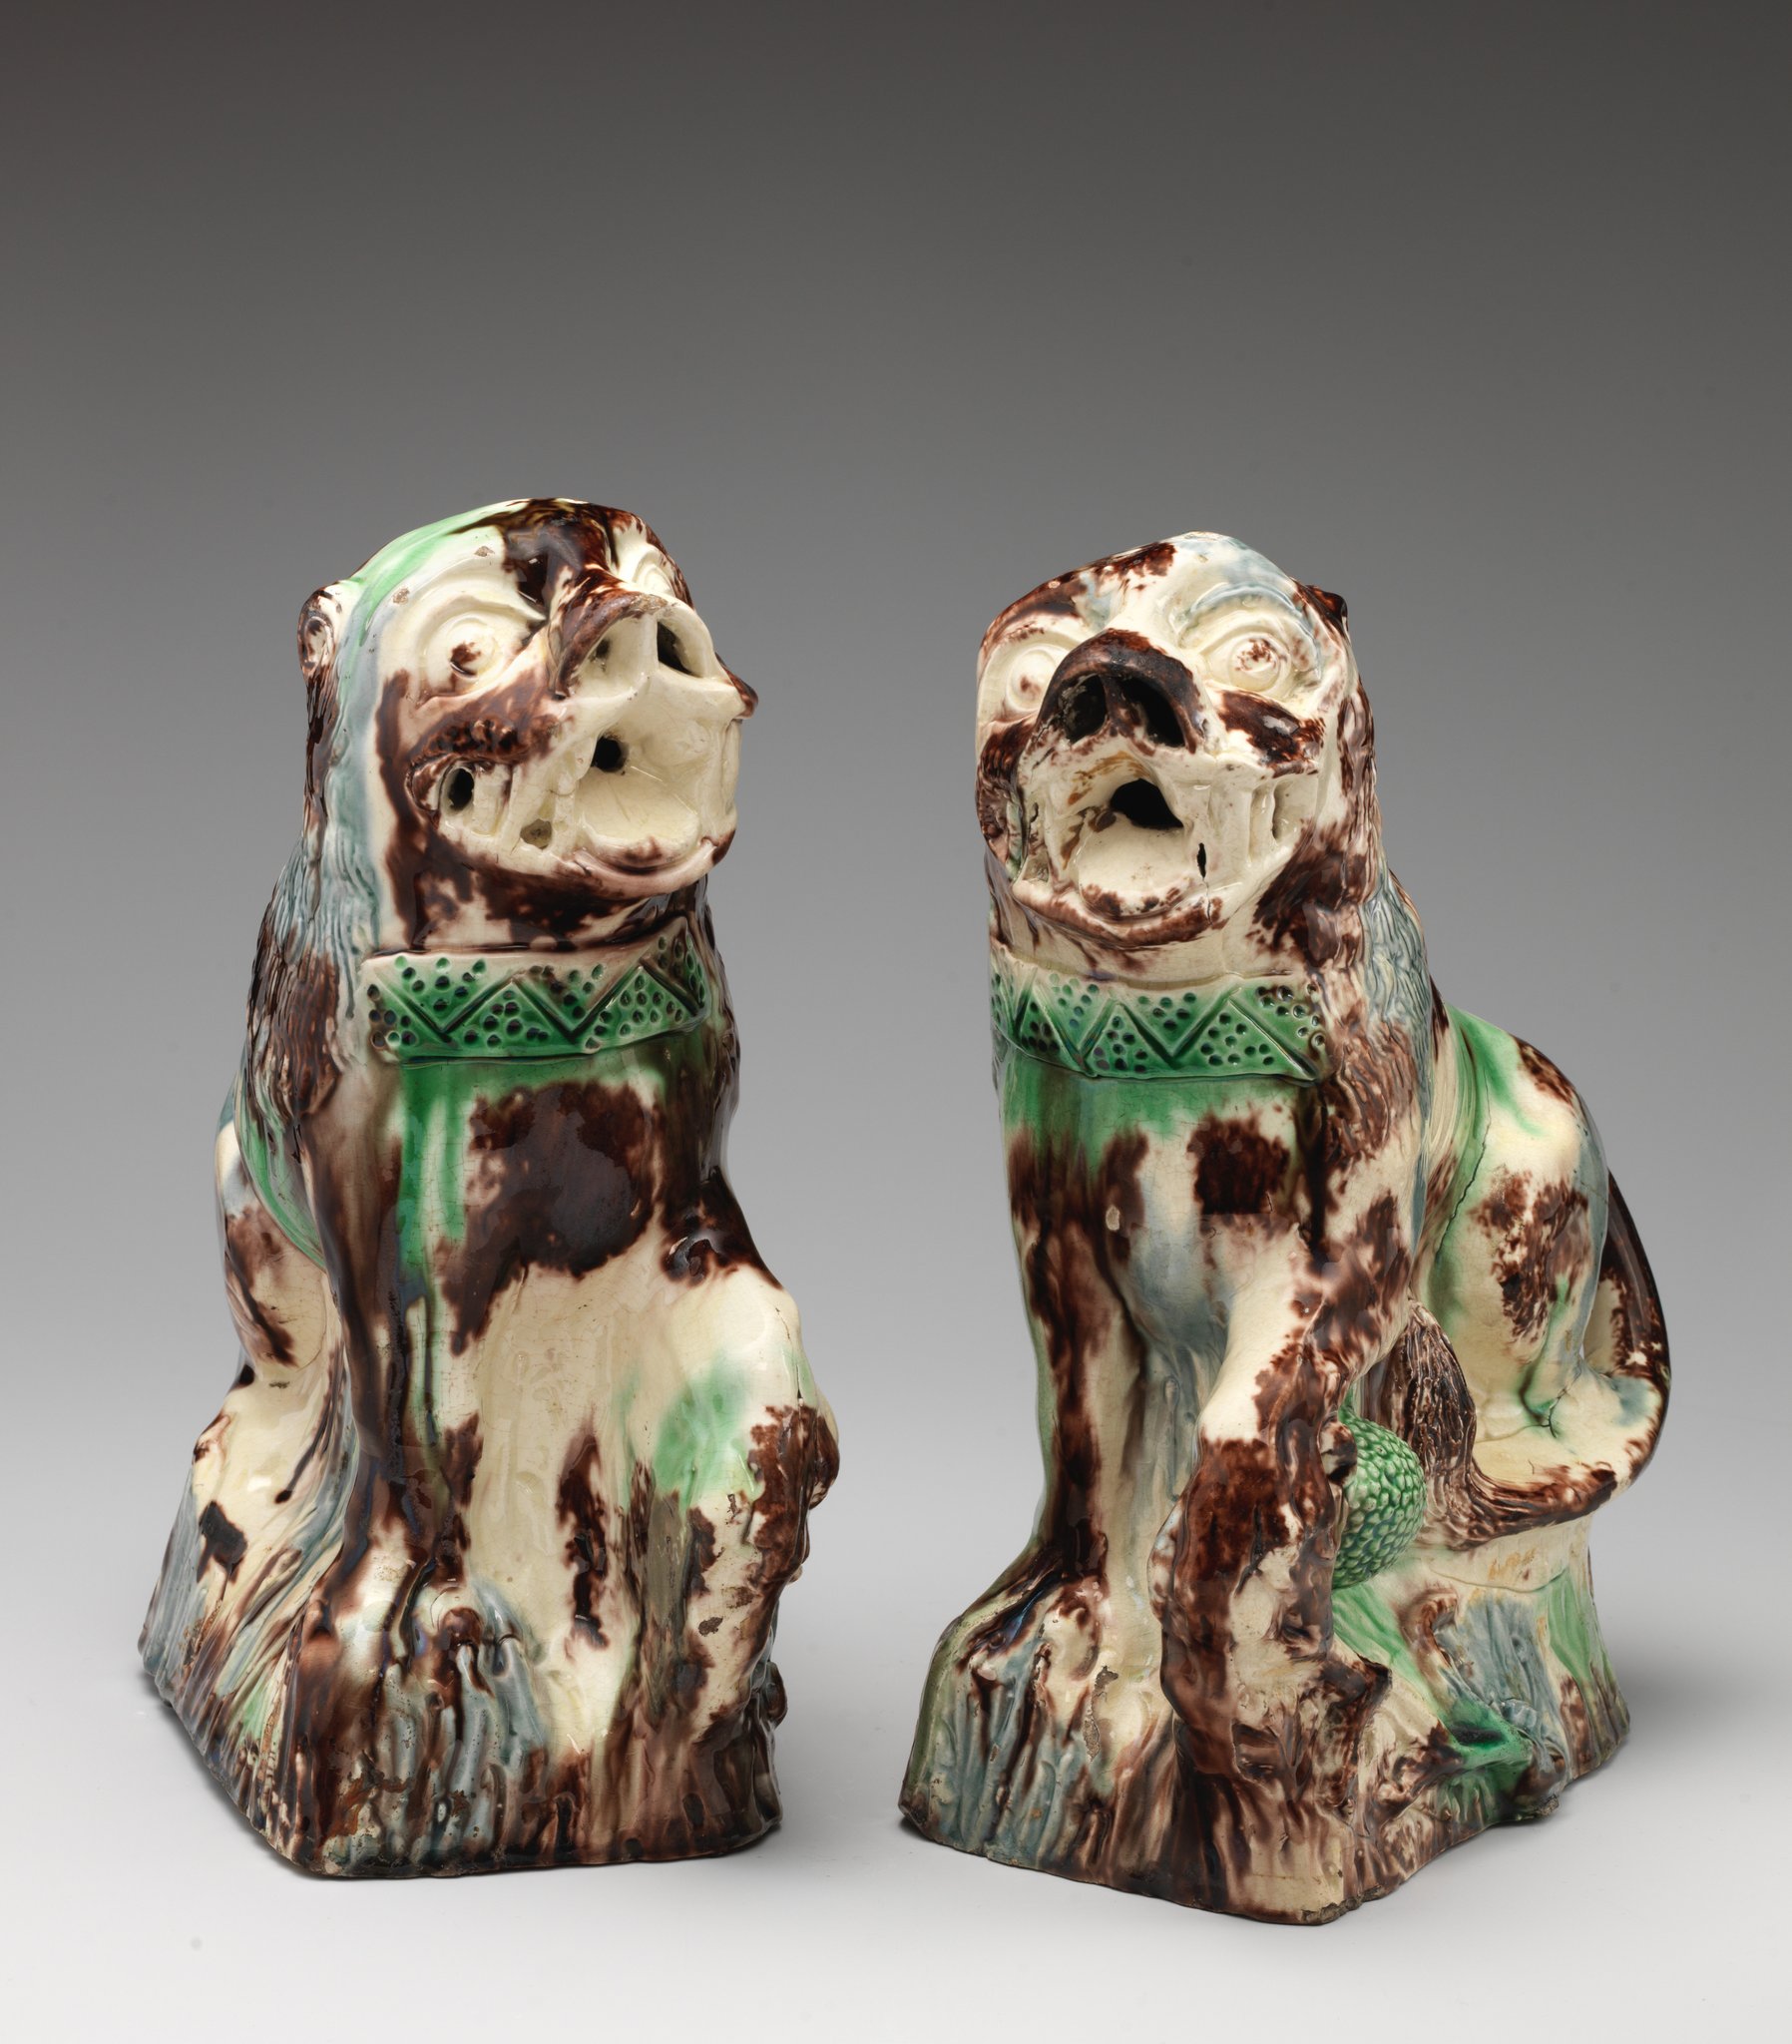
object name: figure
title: Pair of Chinese dogs of Foo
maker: whieldon type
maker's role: artist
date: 1755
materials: earthenware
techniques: glazing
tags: dogs